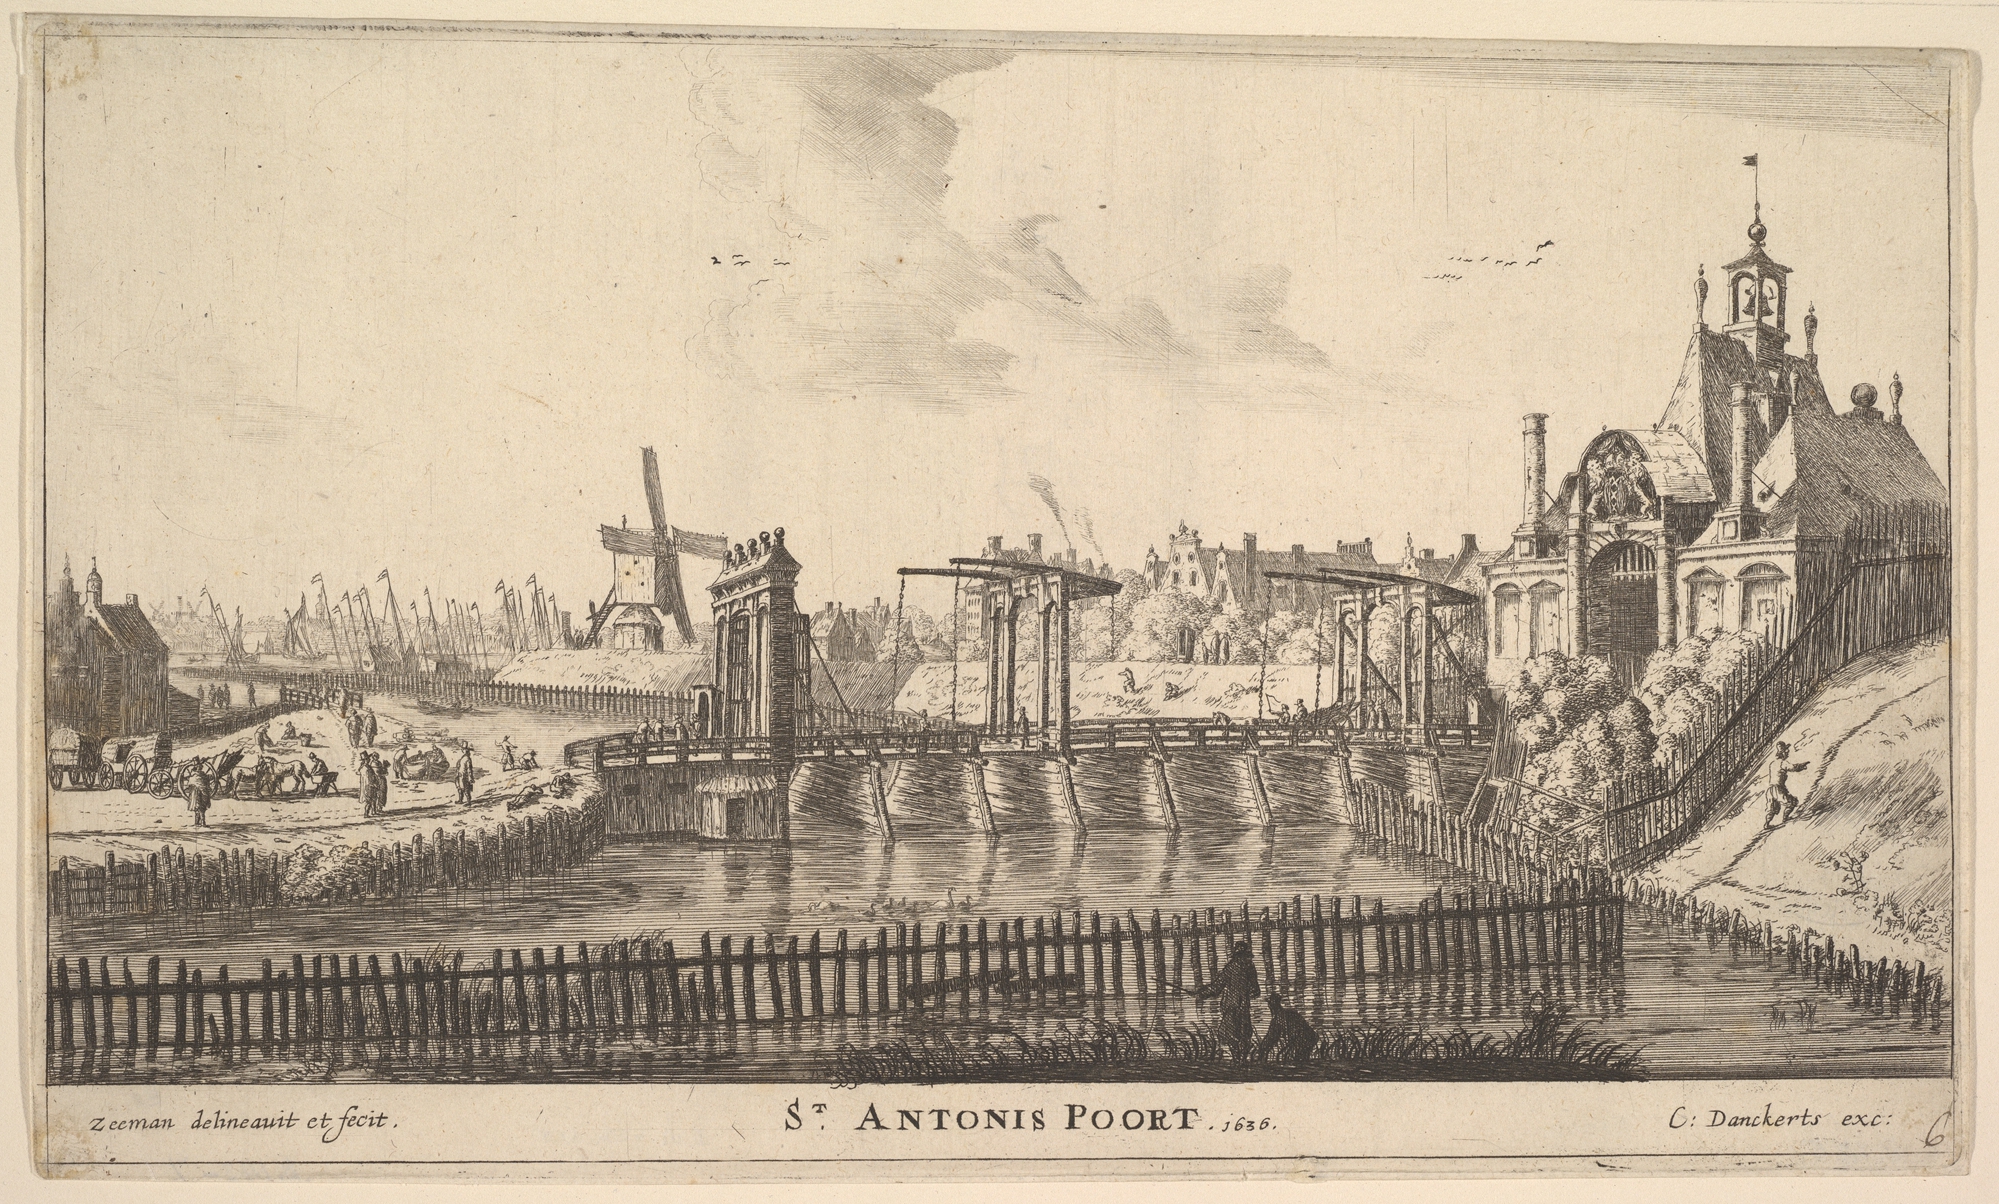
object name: print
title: St. Antonis Poort, Amsterdam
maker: reinier nooms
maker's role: artist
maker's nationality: dutch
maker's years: 1623-1664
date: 1634-1666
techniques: etching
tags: windmills,canals